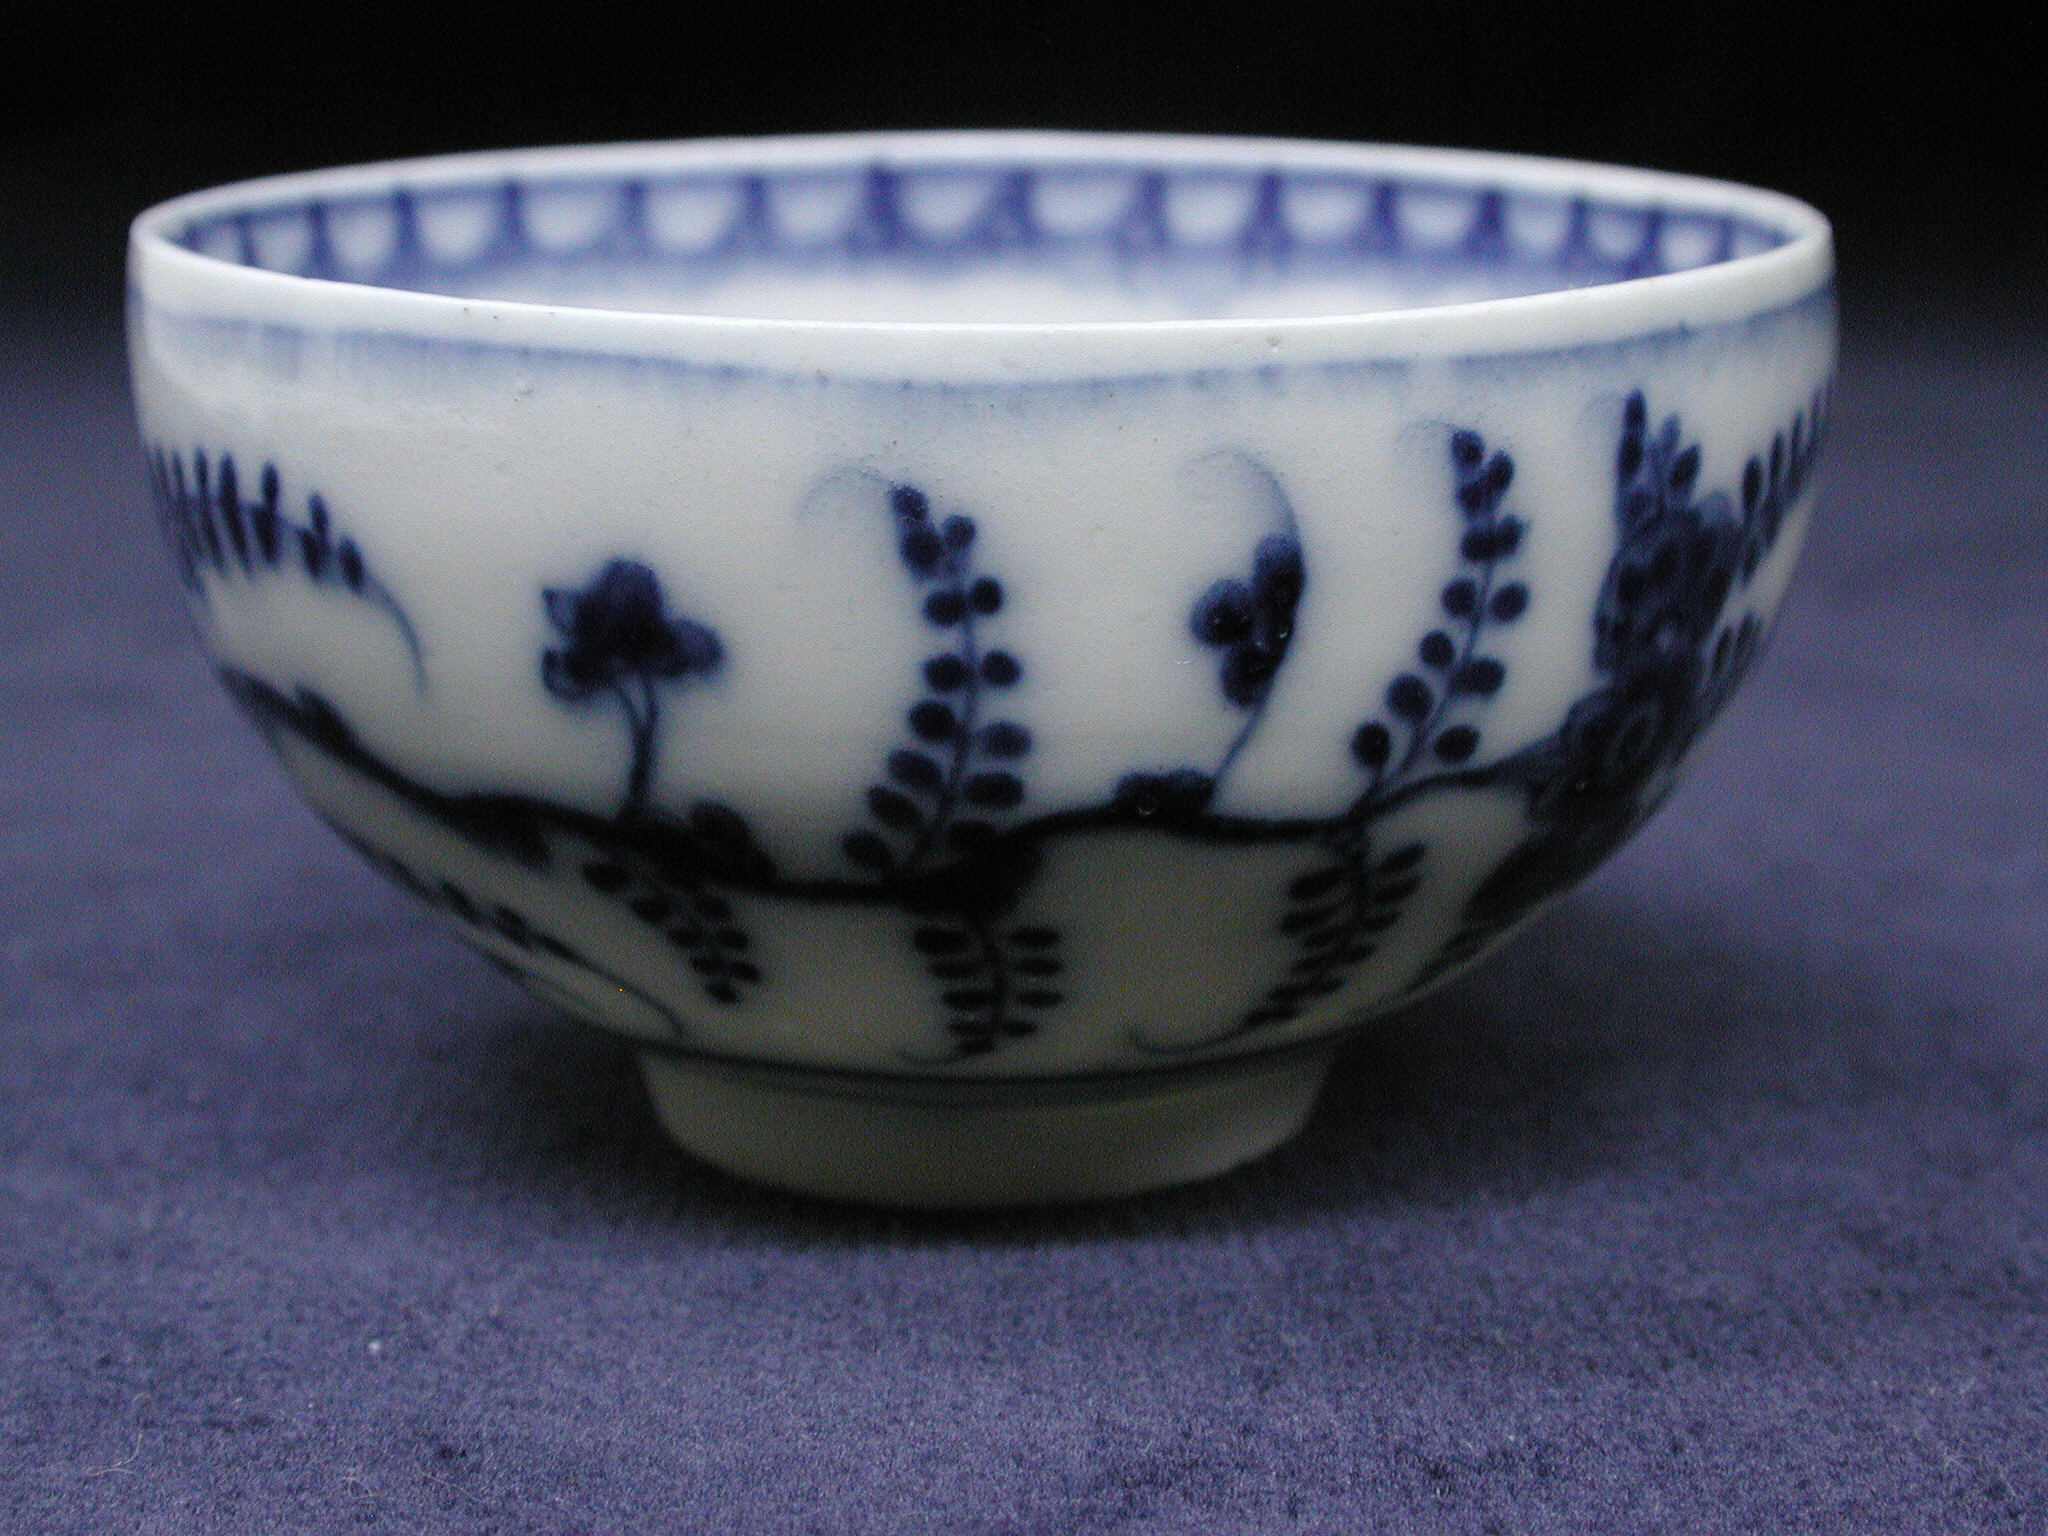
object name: teabowl and saucer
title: Teabowl and saucer (assembled)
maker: zurich pottery and porcelain factory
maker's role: factory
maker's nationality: swiss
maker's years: 1763-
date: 1770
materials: hard paste porcelain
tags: birds